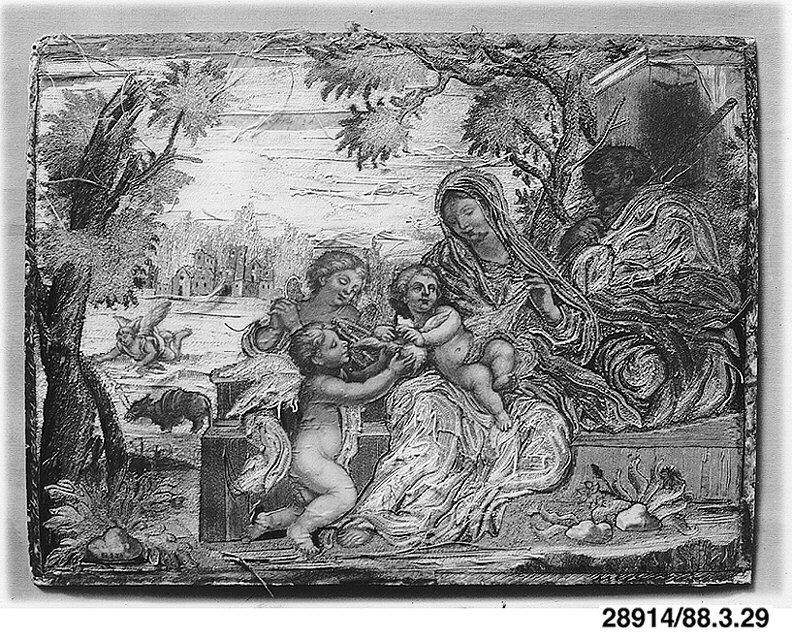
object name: embroidered picture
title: The Holy Family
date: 1667-1700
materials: cardboard, silk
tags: angels,holy family,saint joseph,virgin mary,jesus